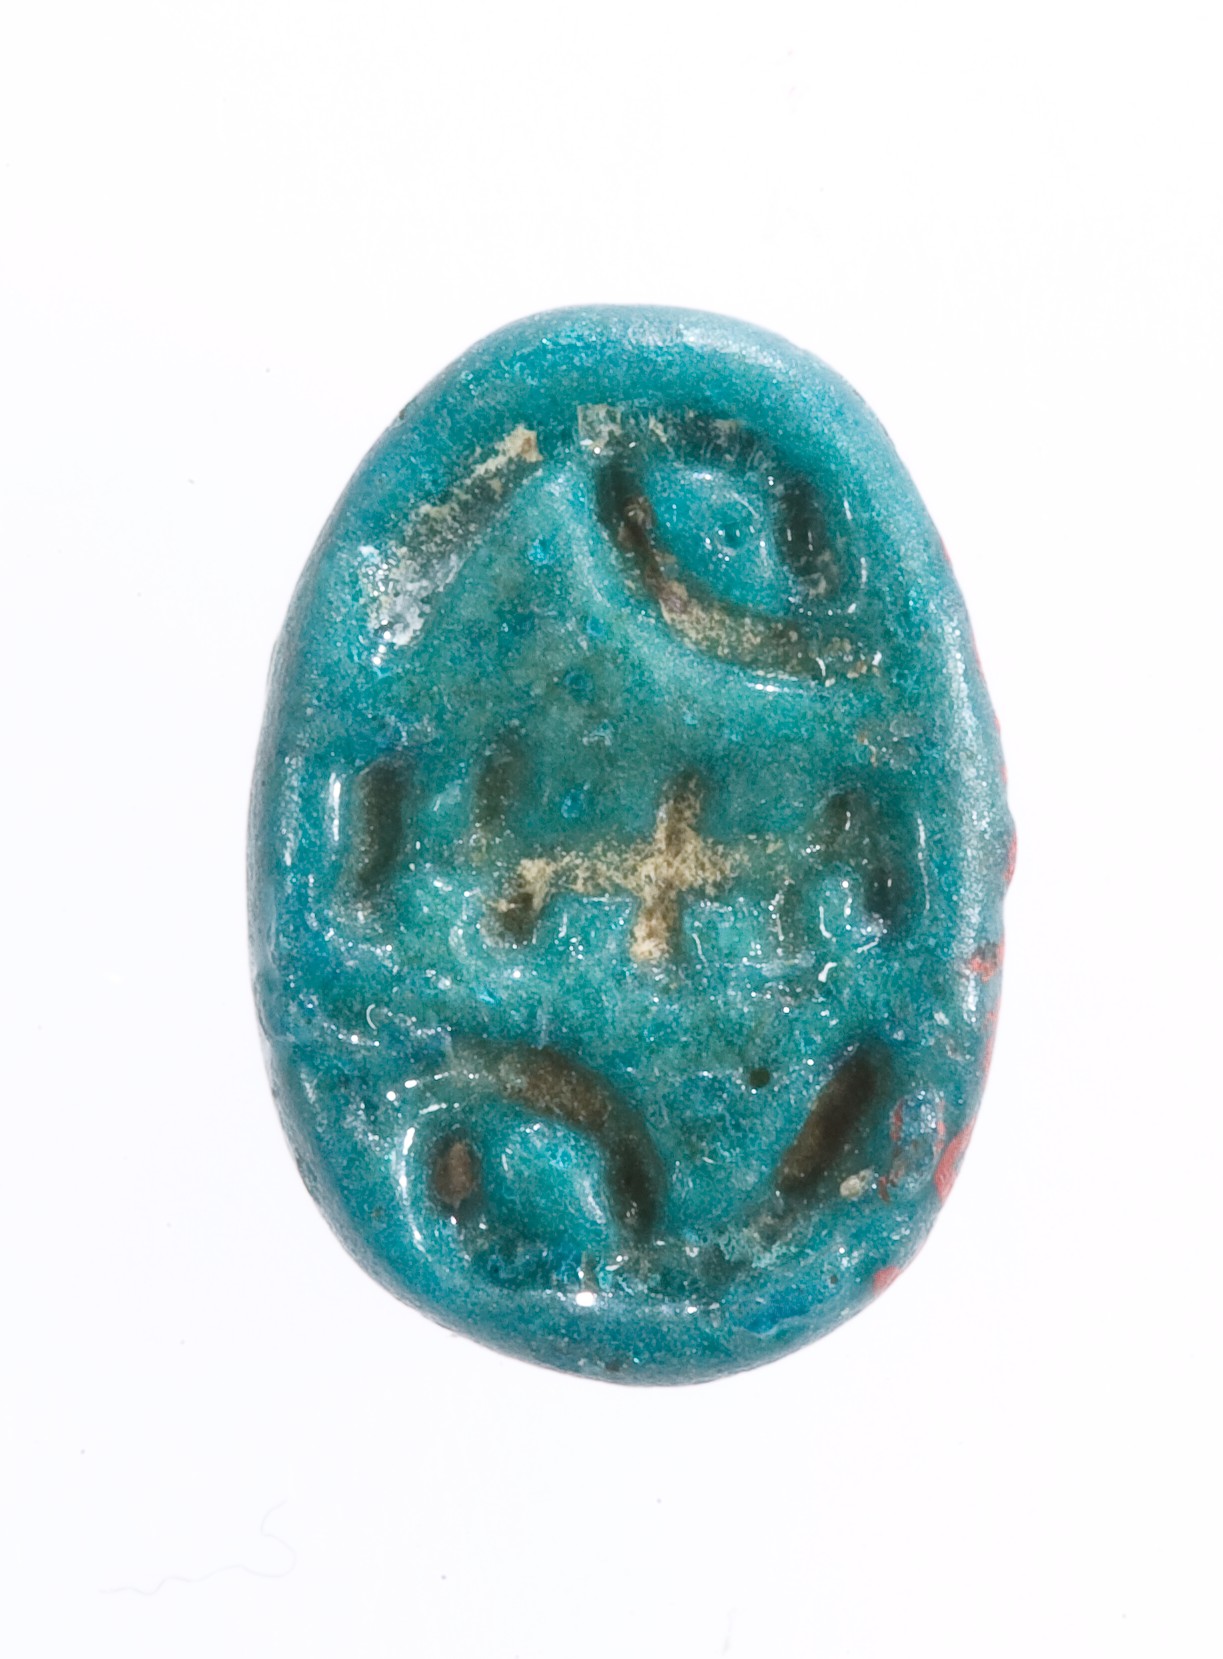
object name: scarab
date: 1635-1458 BCE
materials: faience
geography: egypt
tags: scarabs